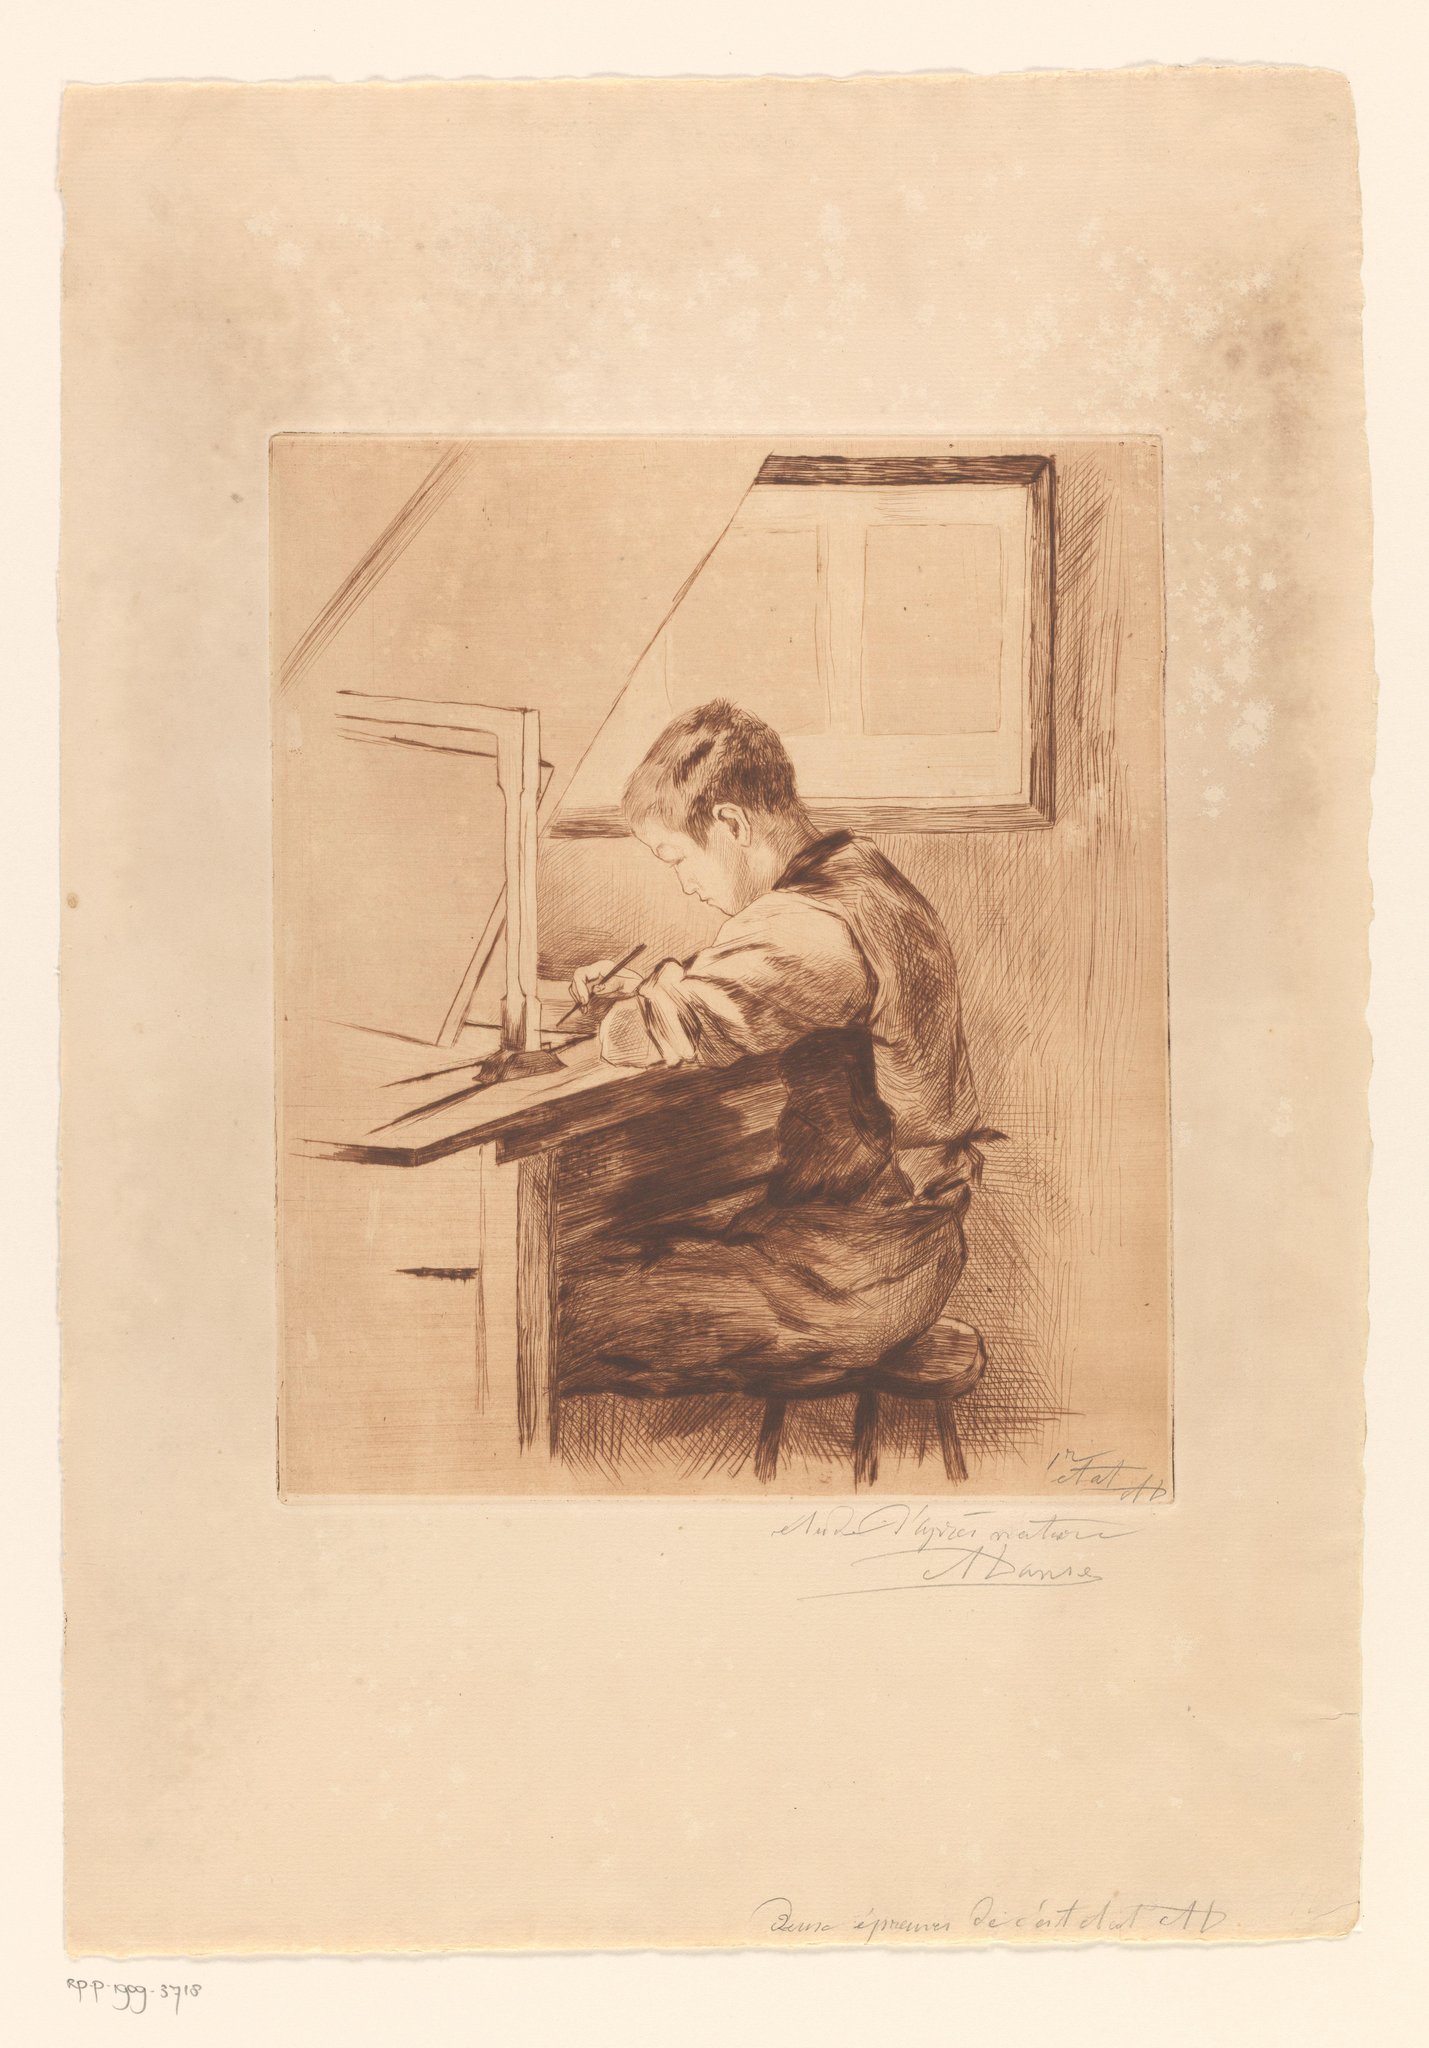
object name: print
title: Jonge graveur aan het werk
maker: auguste danse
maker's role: print maker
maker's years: 1829-1929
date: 1895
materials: paper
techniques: drypoint, etching, intaglio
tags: engraver, etcher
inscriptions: annotation: ‘1er etat; étude d'après nature; deux épreuves de c'est etat’, collector's mark: Lugt 2228